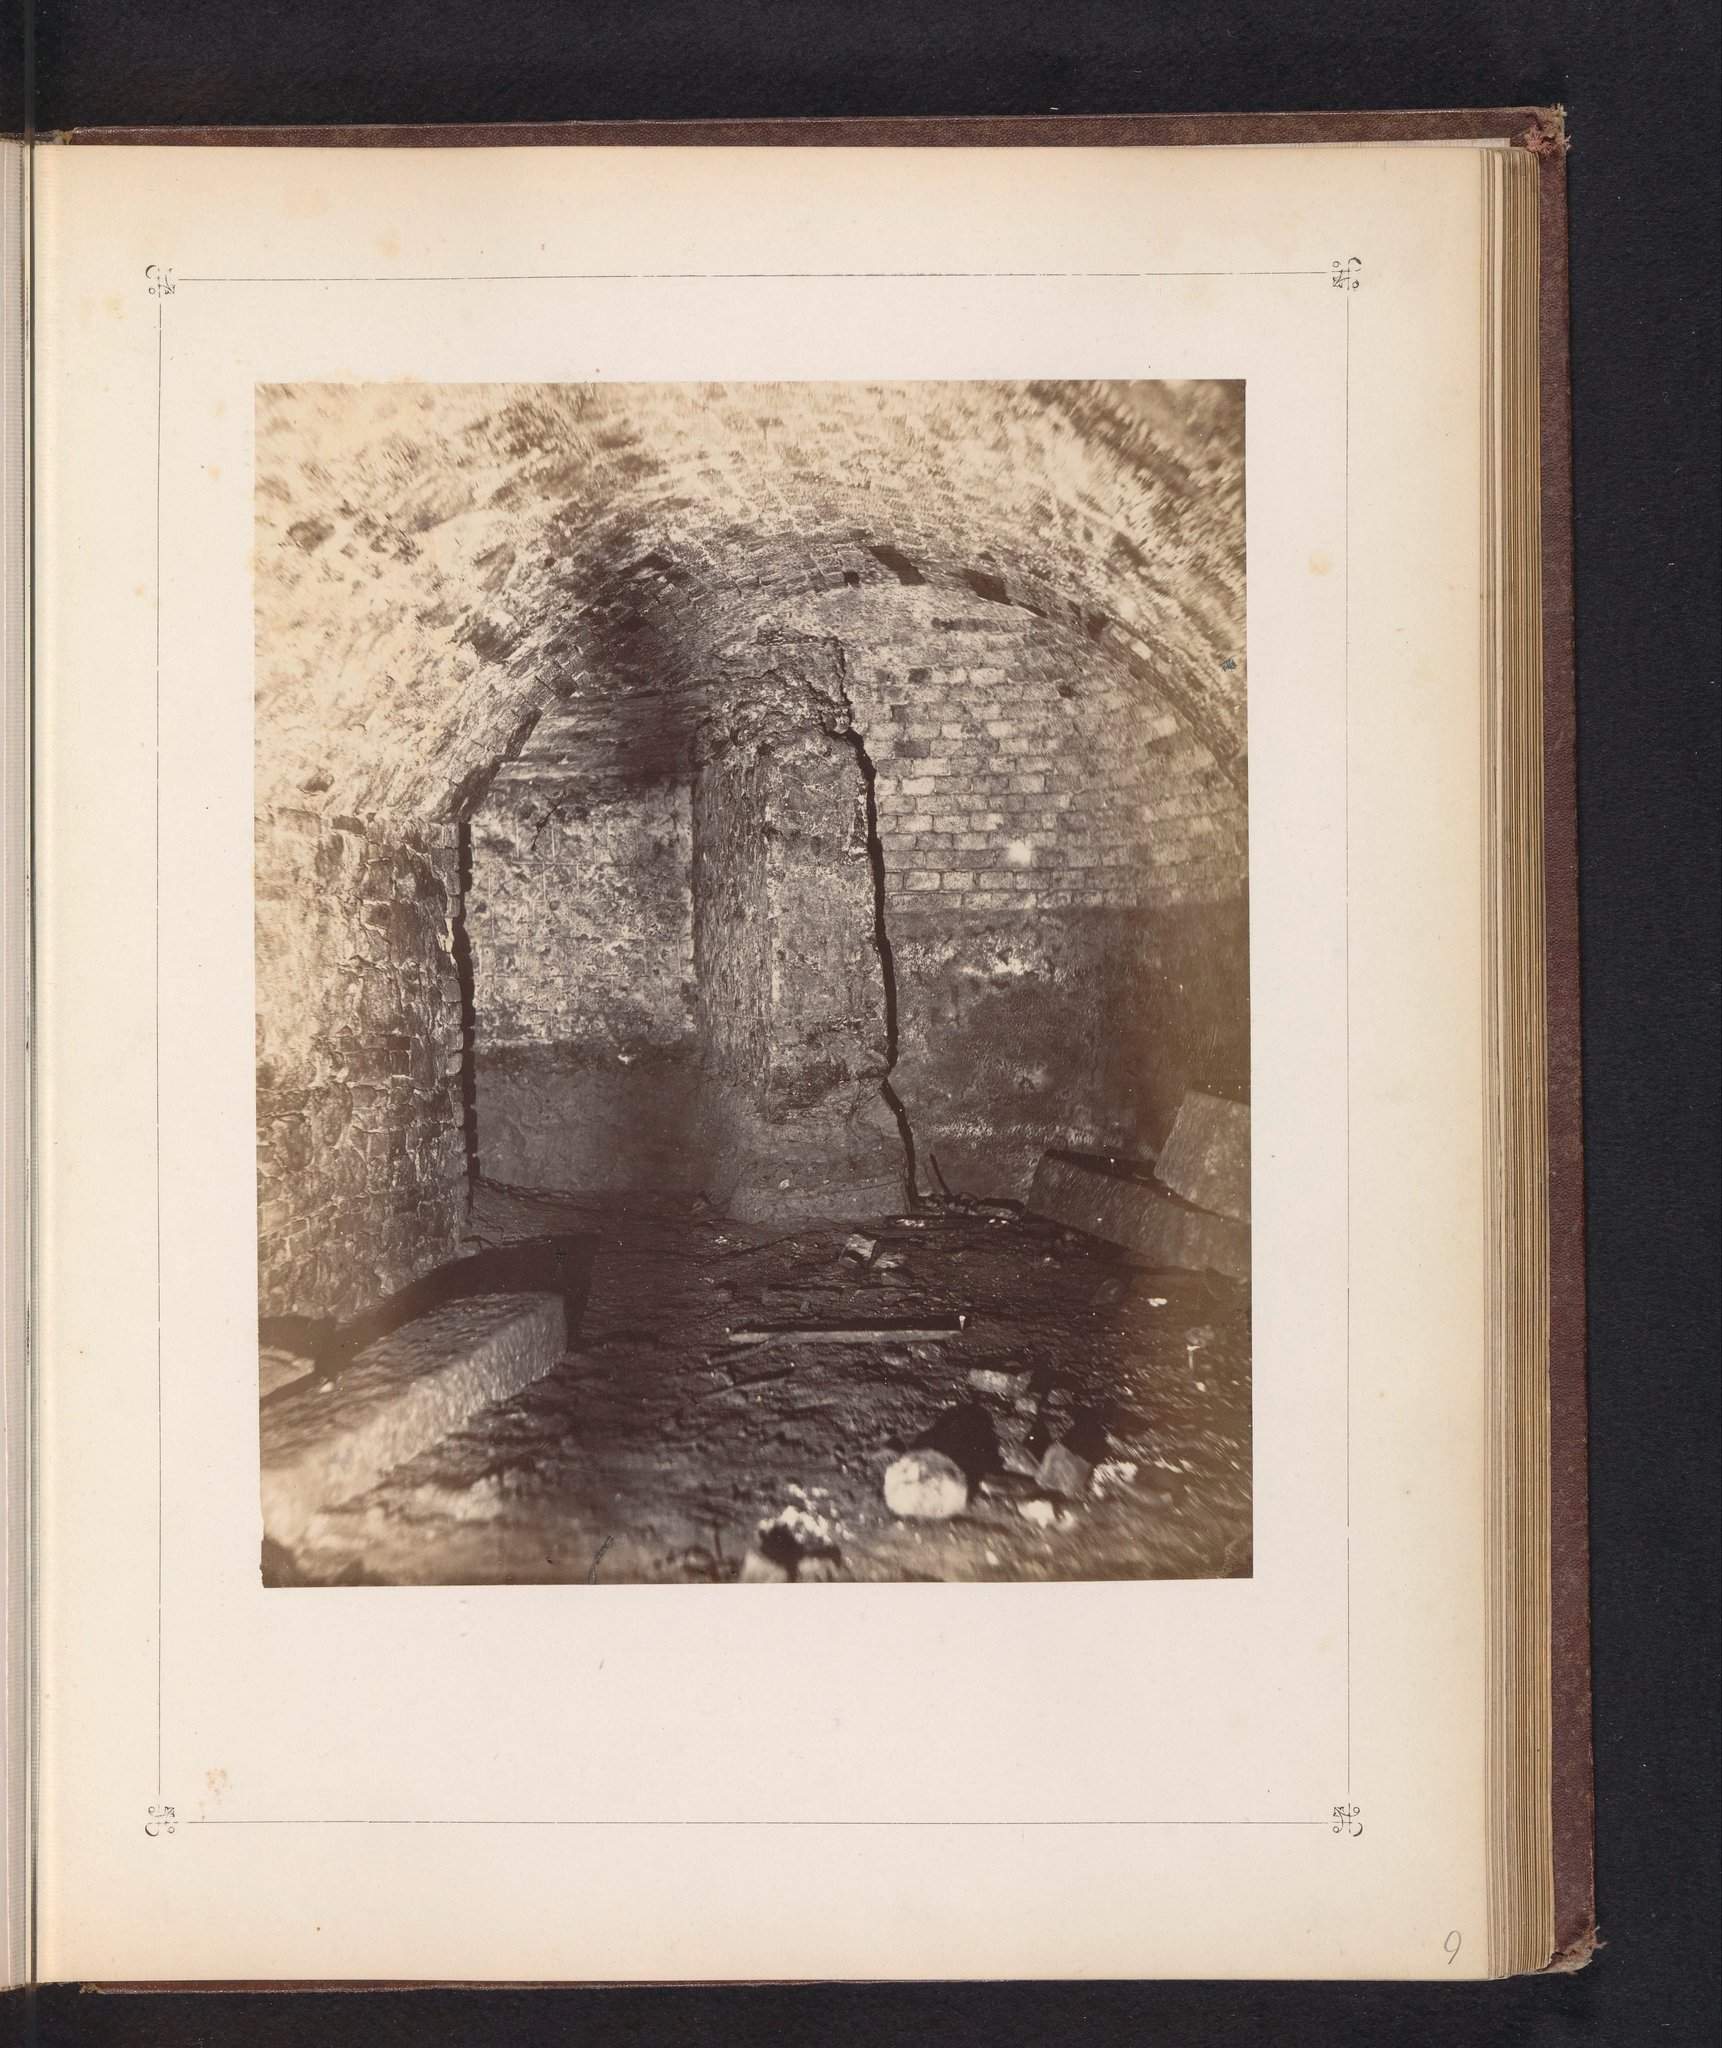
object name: page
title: Interieur van de voormalige drukkerij van Johannes Gutenberg te Mainz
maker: b. erdmann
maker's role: fotograaf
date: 1867-1872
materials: photographic support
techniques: albumen print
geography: mainz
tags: printing, printing office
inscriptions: number: ‘9’